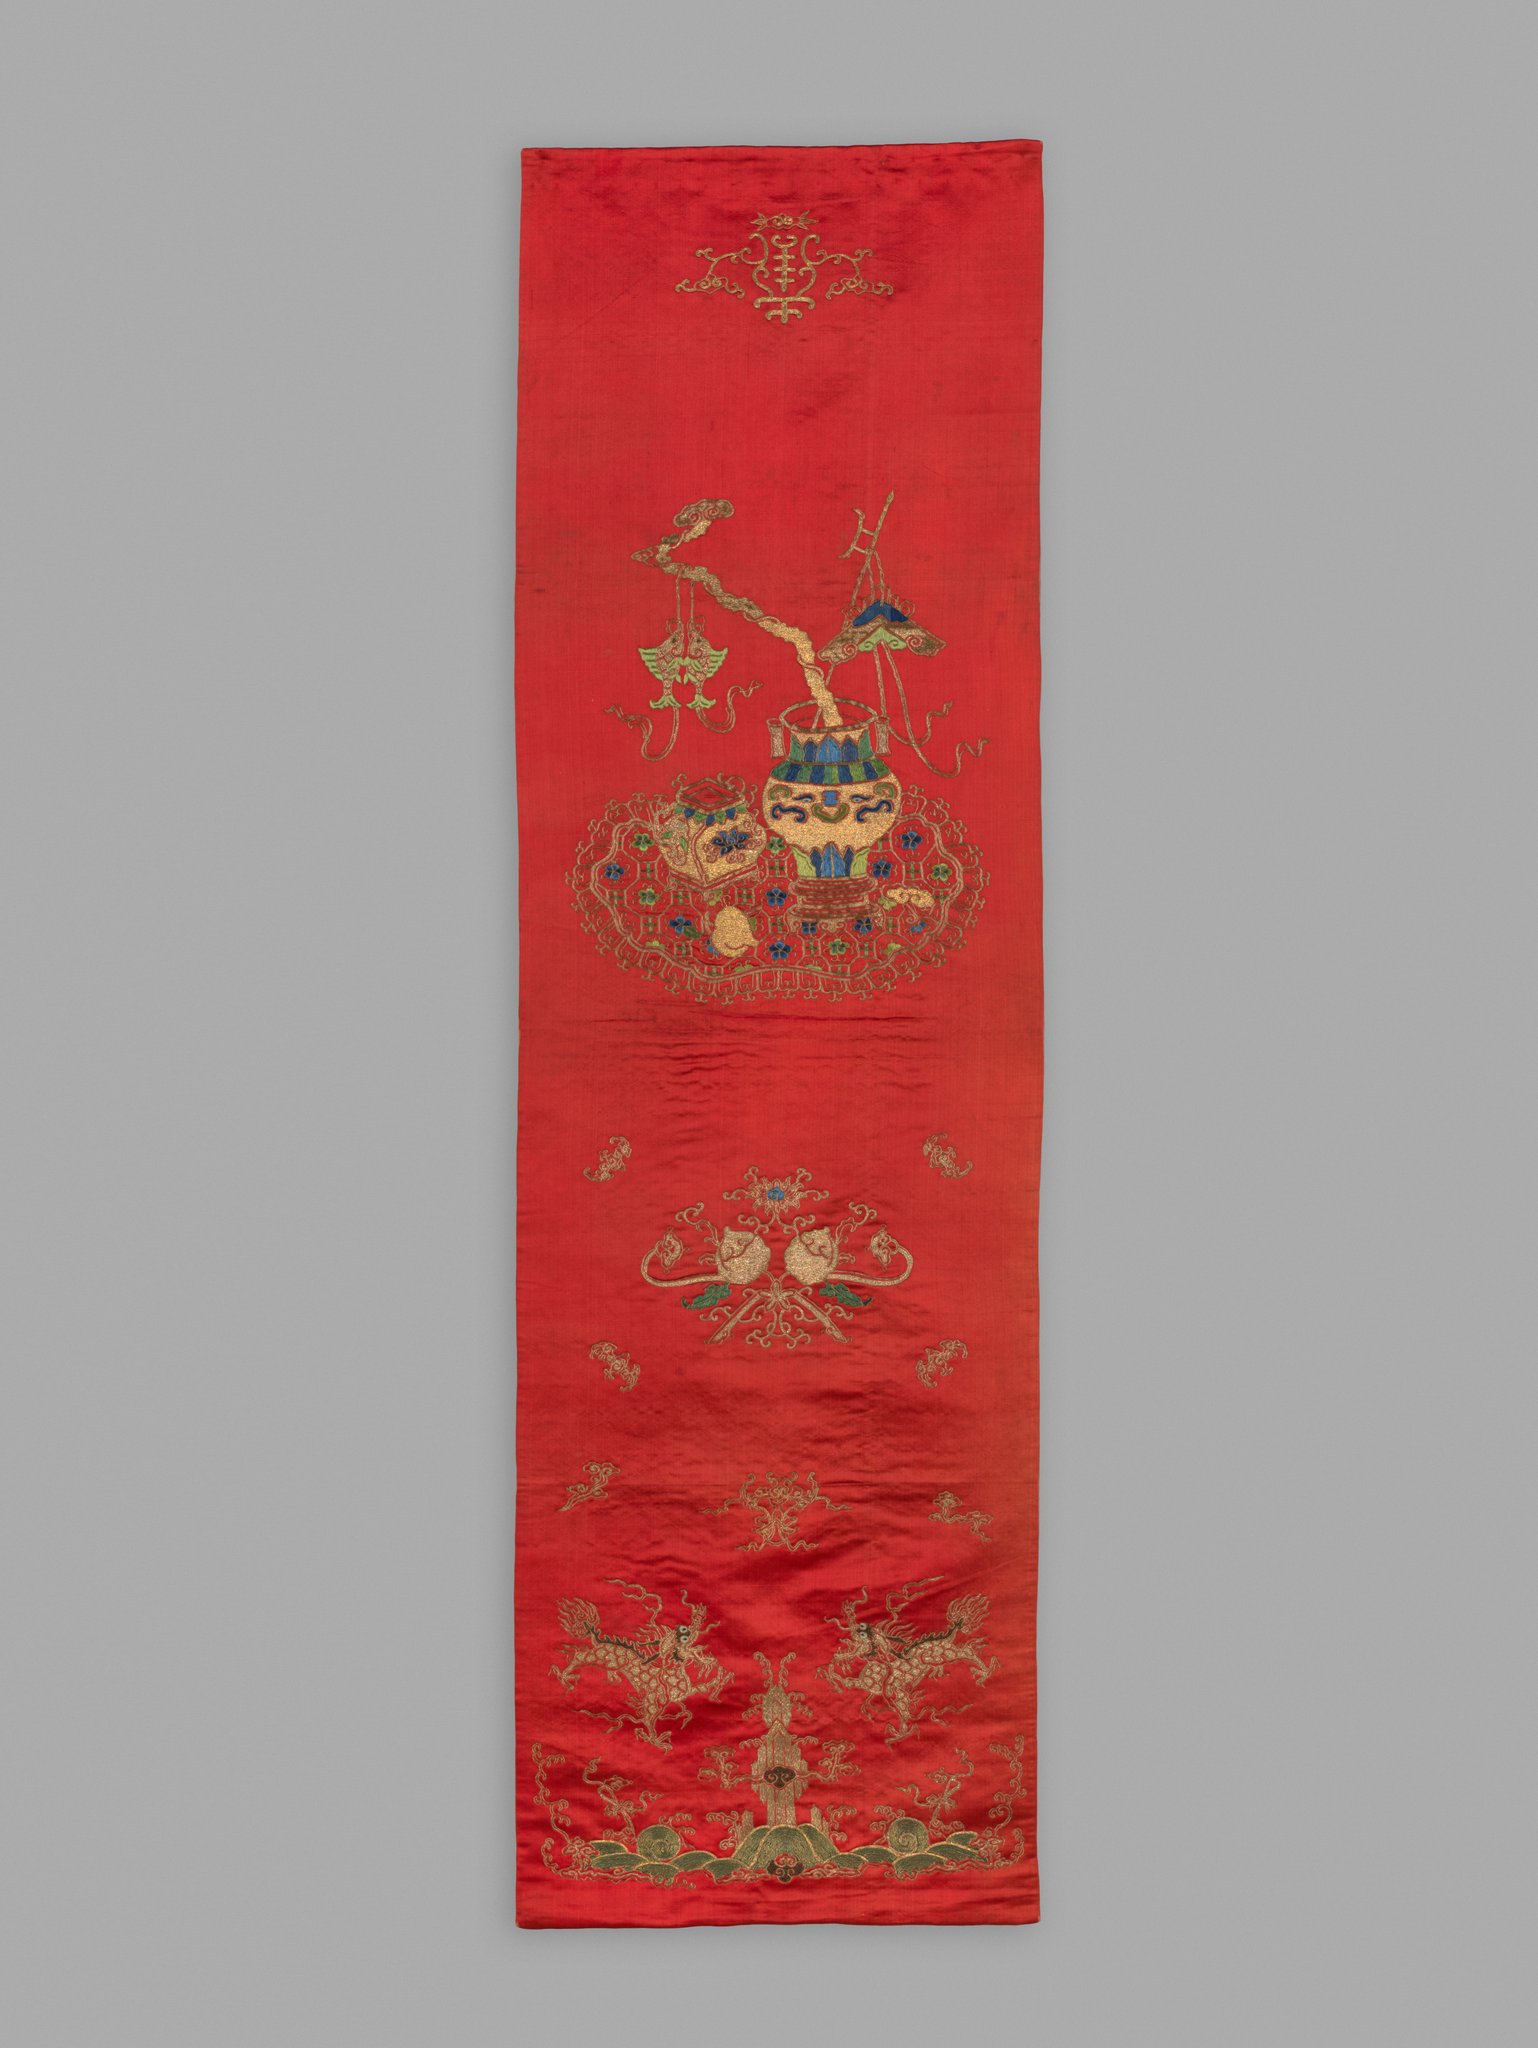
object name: chair strip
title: Chair Strip with Antiquities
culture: chinese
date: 1736-1795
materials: metal thread, silk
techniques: embroidery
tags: fish